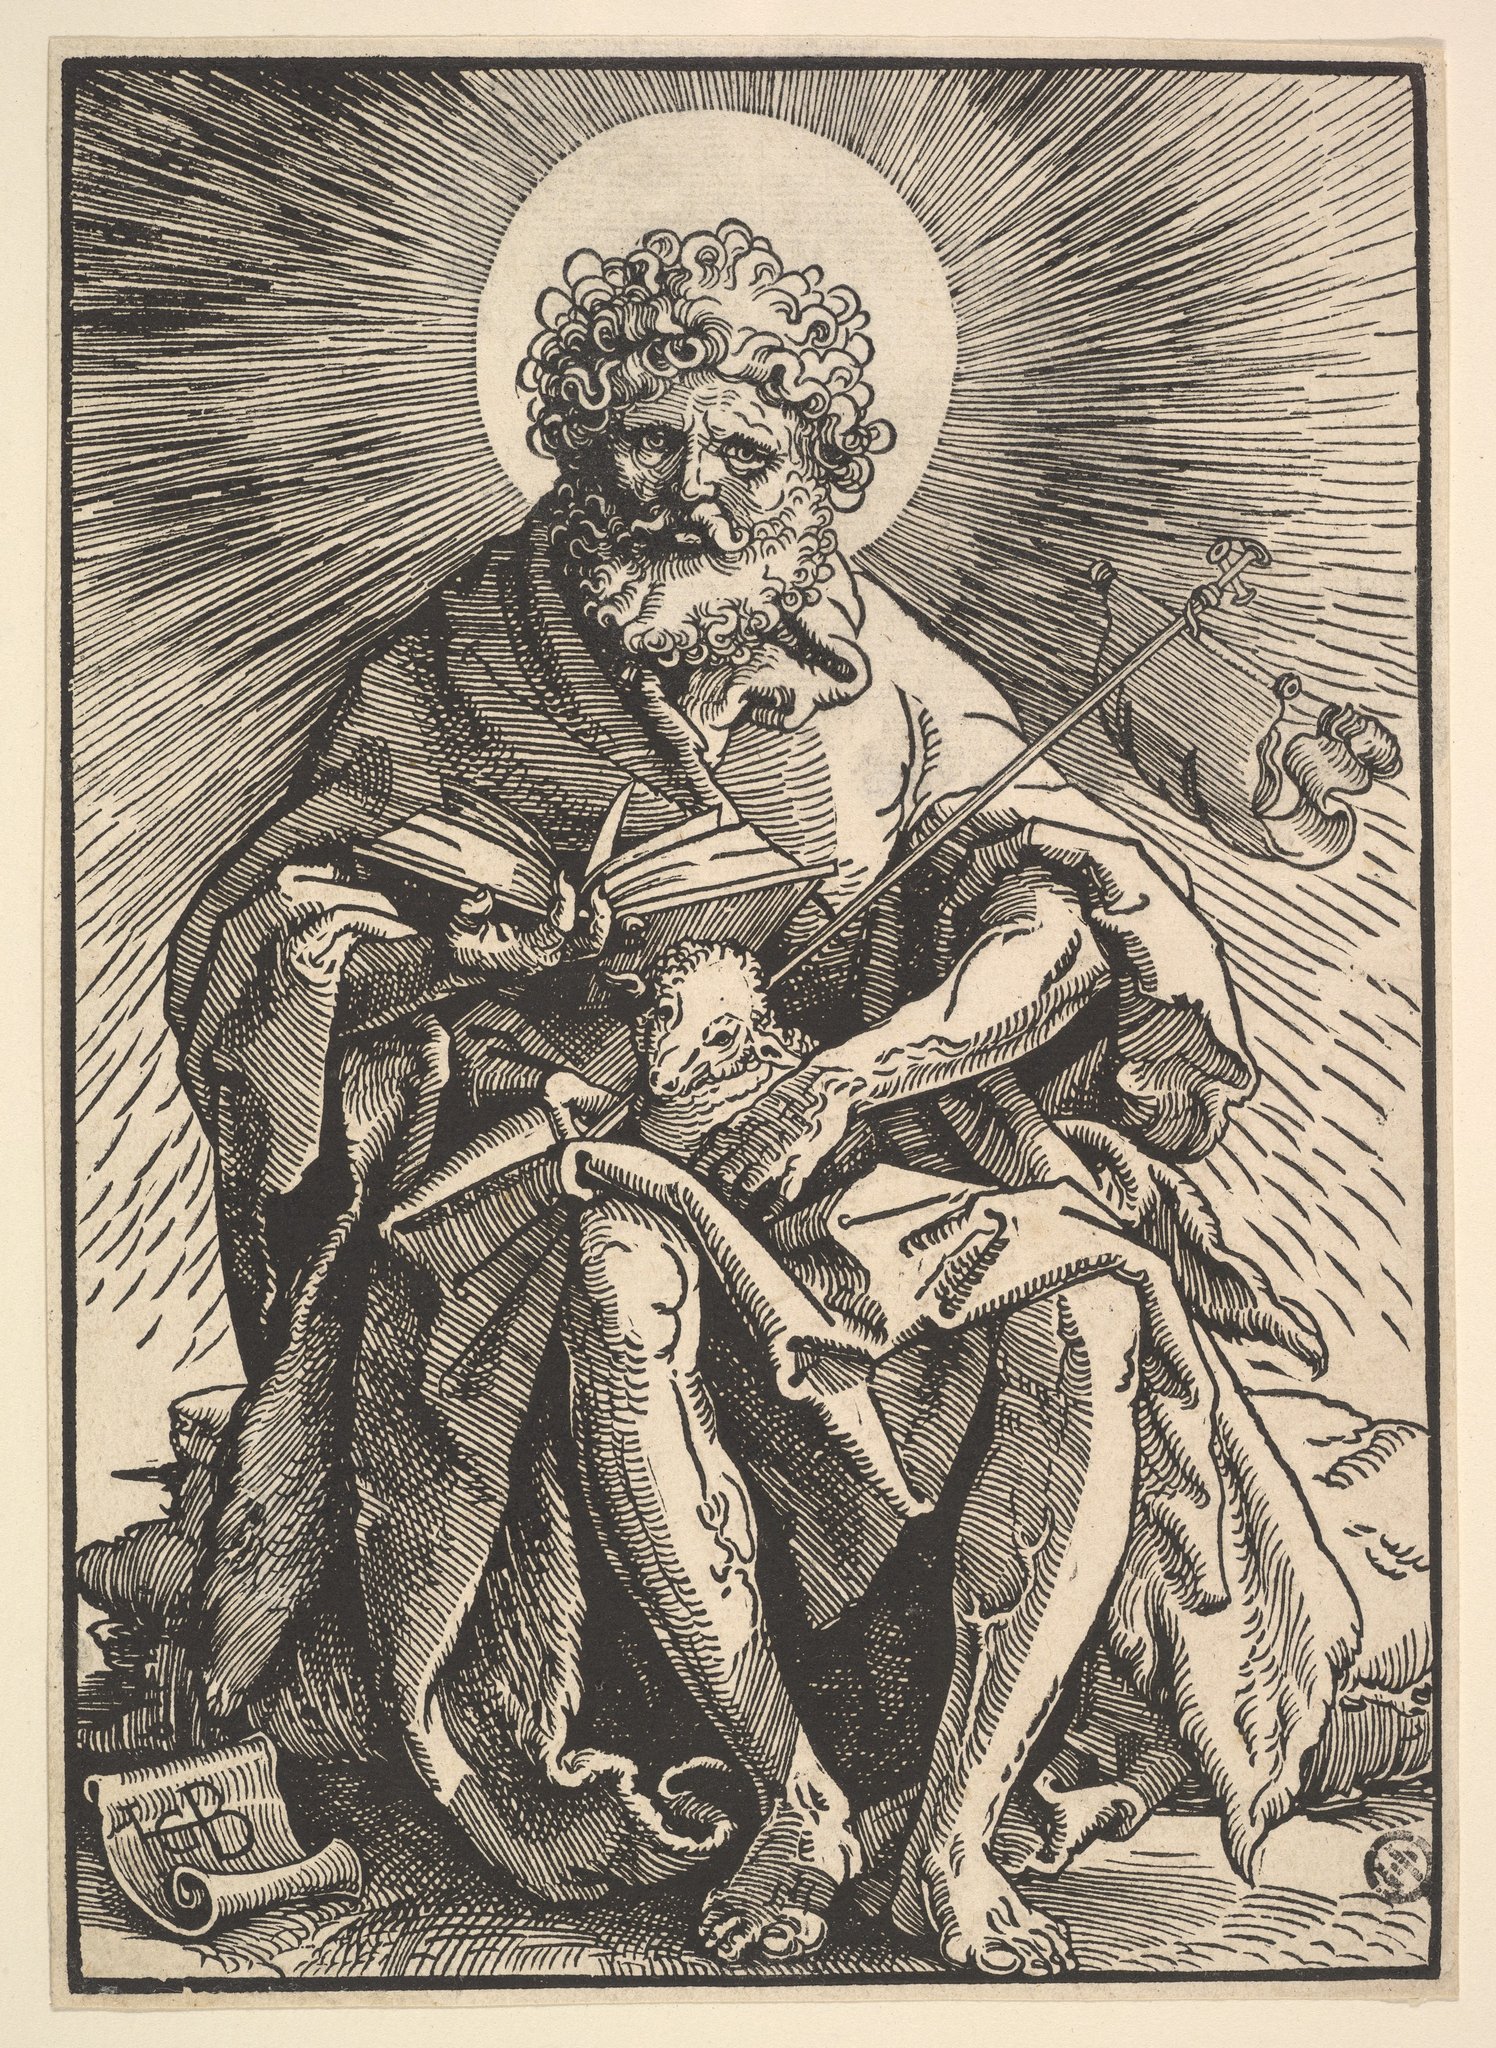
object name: print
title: St. John the Baptist Holding the Lamb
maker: hans baldung (called hans baldung grien)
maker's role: artist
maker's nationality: german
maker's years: 1484-1545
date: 1517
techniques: woodcut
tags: lambs,saint john the baptist